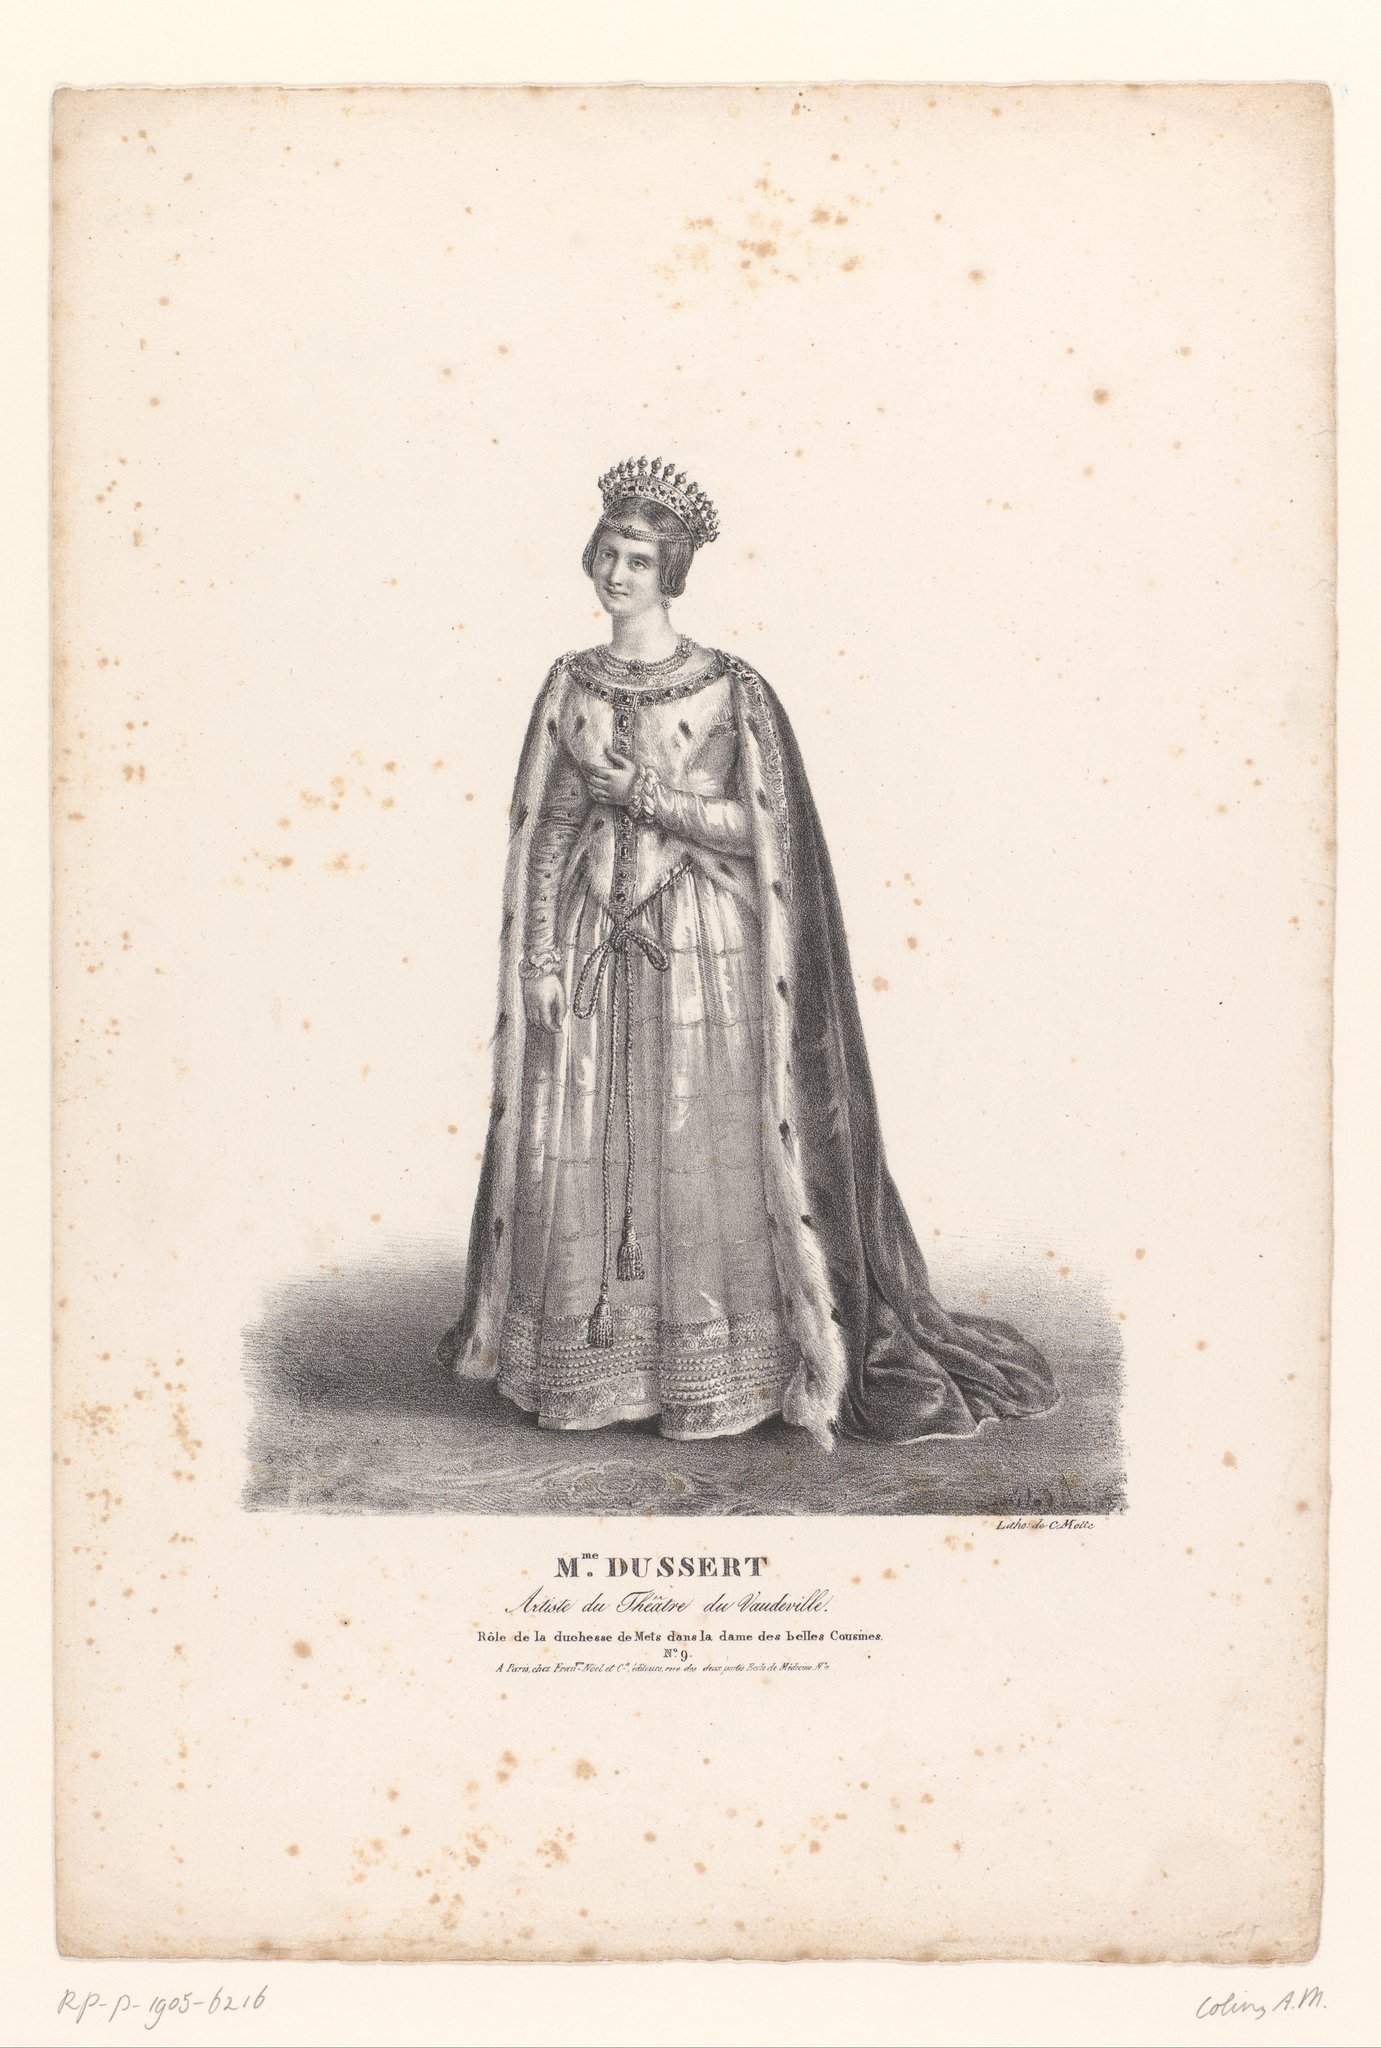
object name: print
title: Portret van Anne Dussert als Duchesse de Mets in de vaudeville La Dame des Belles Cousines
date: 1823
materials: paper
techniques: lithograph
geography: paris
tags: stage costume, portrait of actor, actress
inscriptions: collector's mark: Lugt 2228a